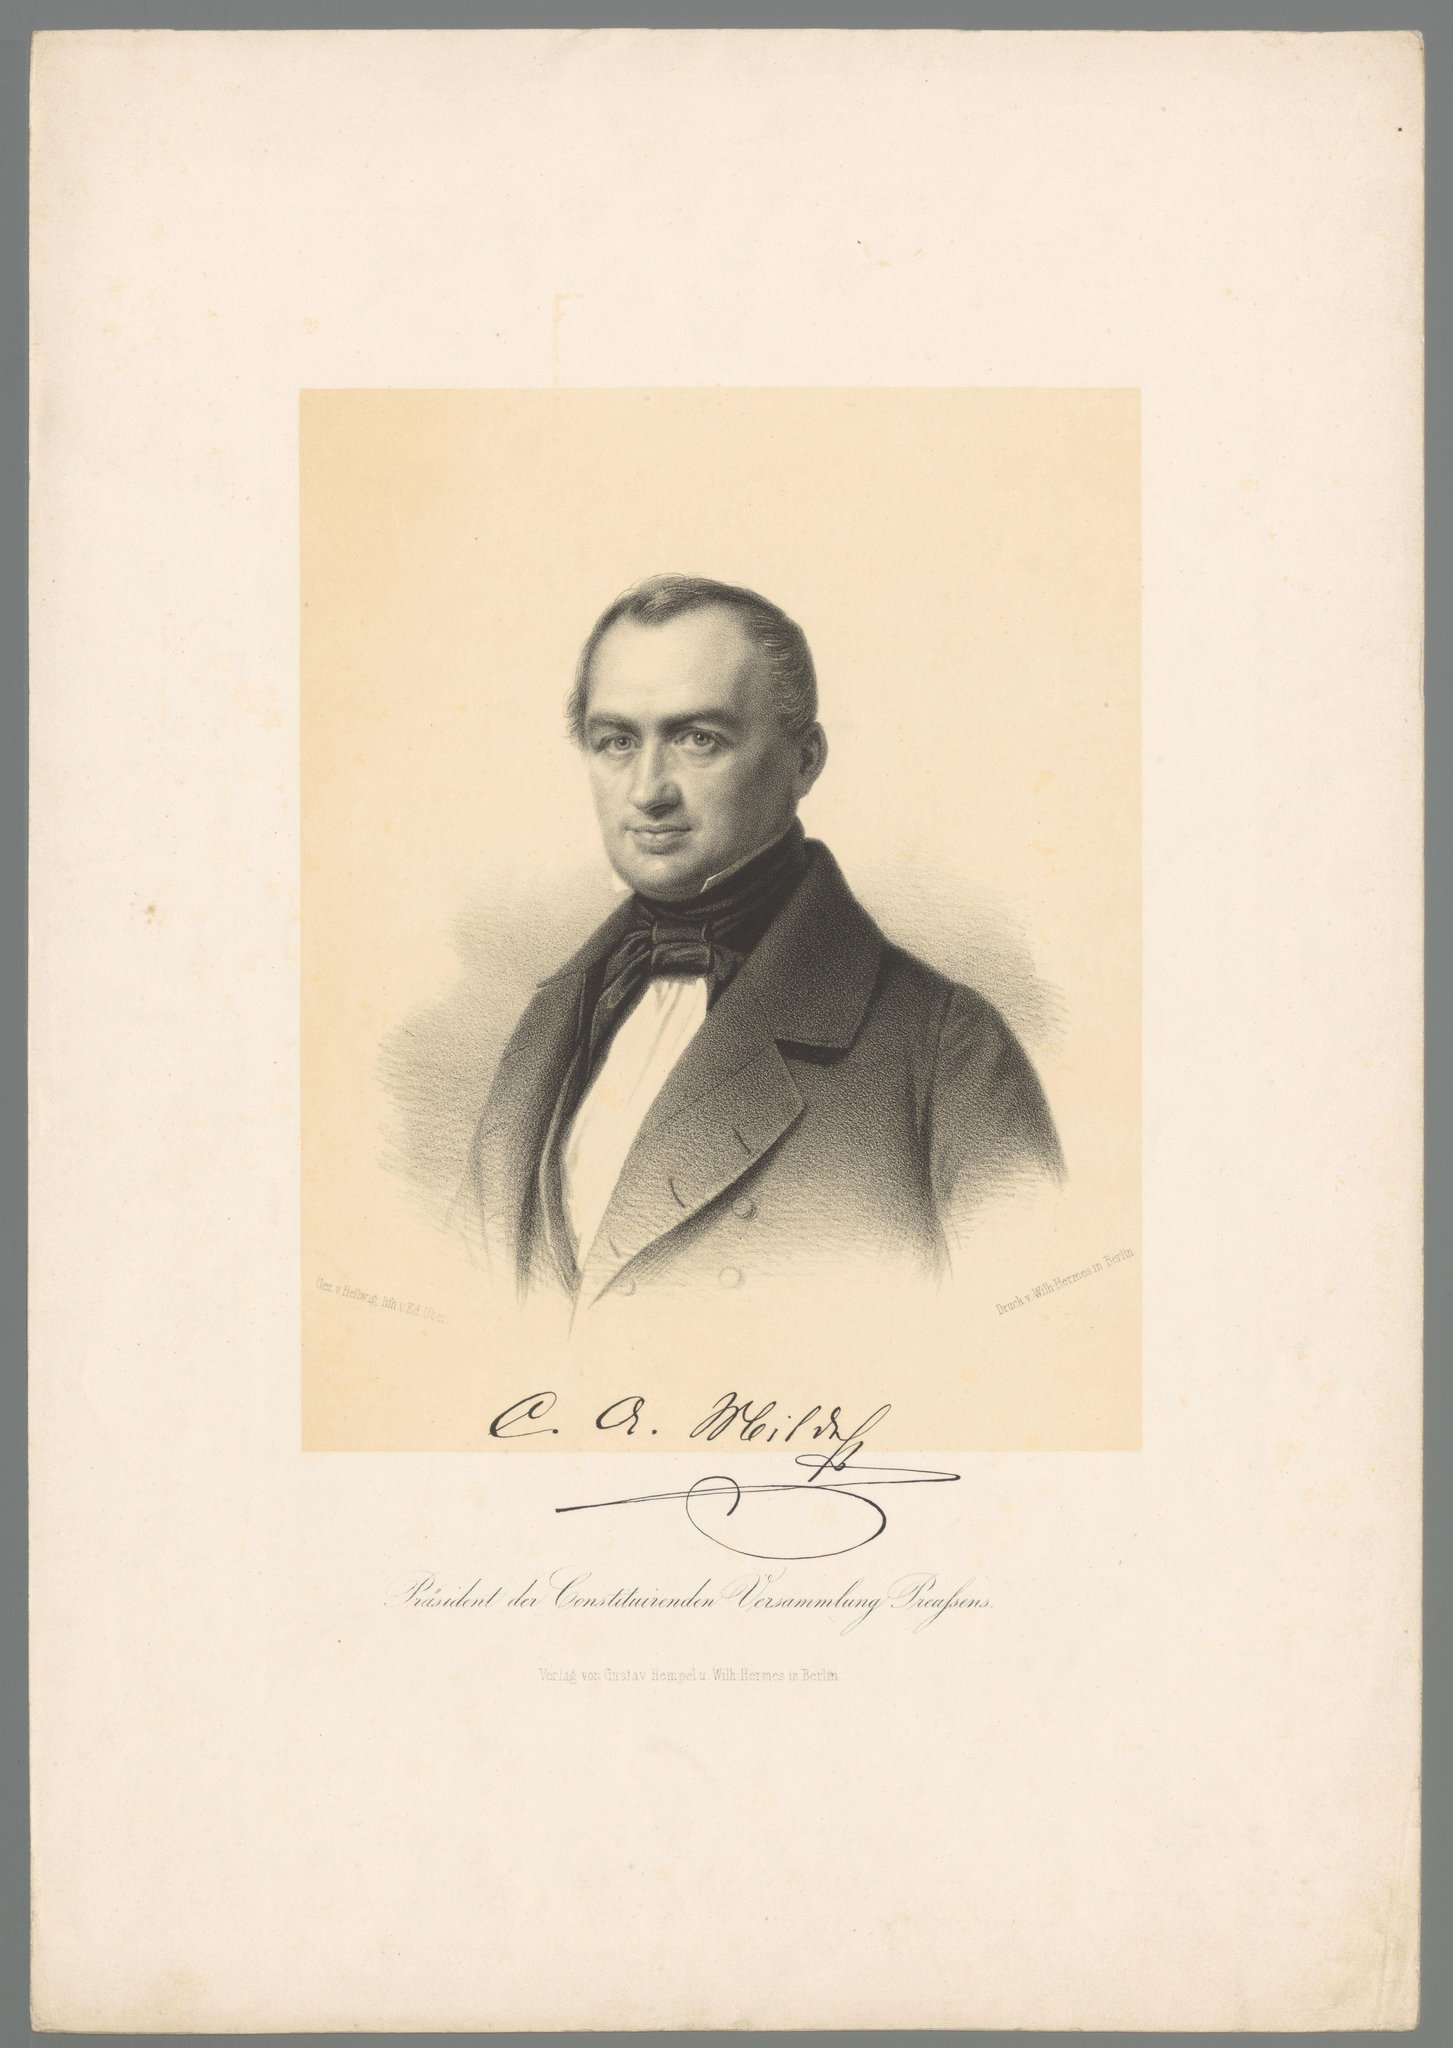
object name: print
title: Portret van een onbekende man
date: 1838-1848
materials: paper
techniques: tone lithography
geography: berlin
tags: historical persons not known by name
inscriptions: collector's mark: Lugt 2228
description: Portret van een verder onbekende man, met handtekening in facsimile waarin mogelijk de naam Weilch te lezen is.